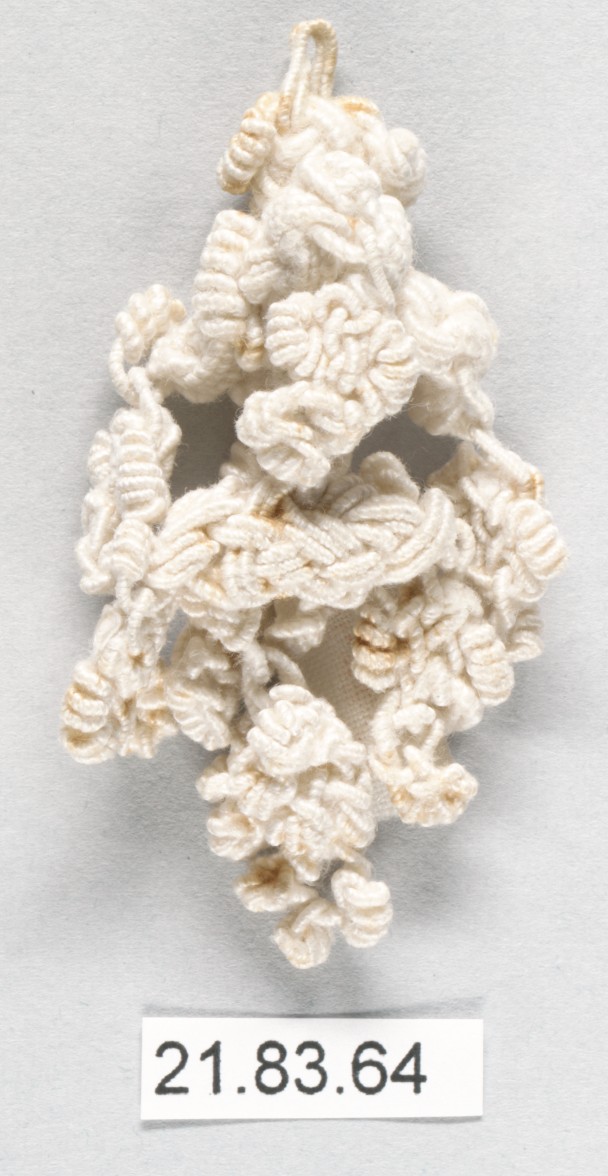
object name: tassel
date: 1601-1700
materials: linen